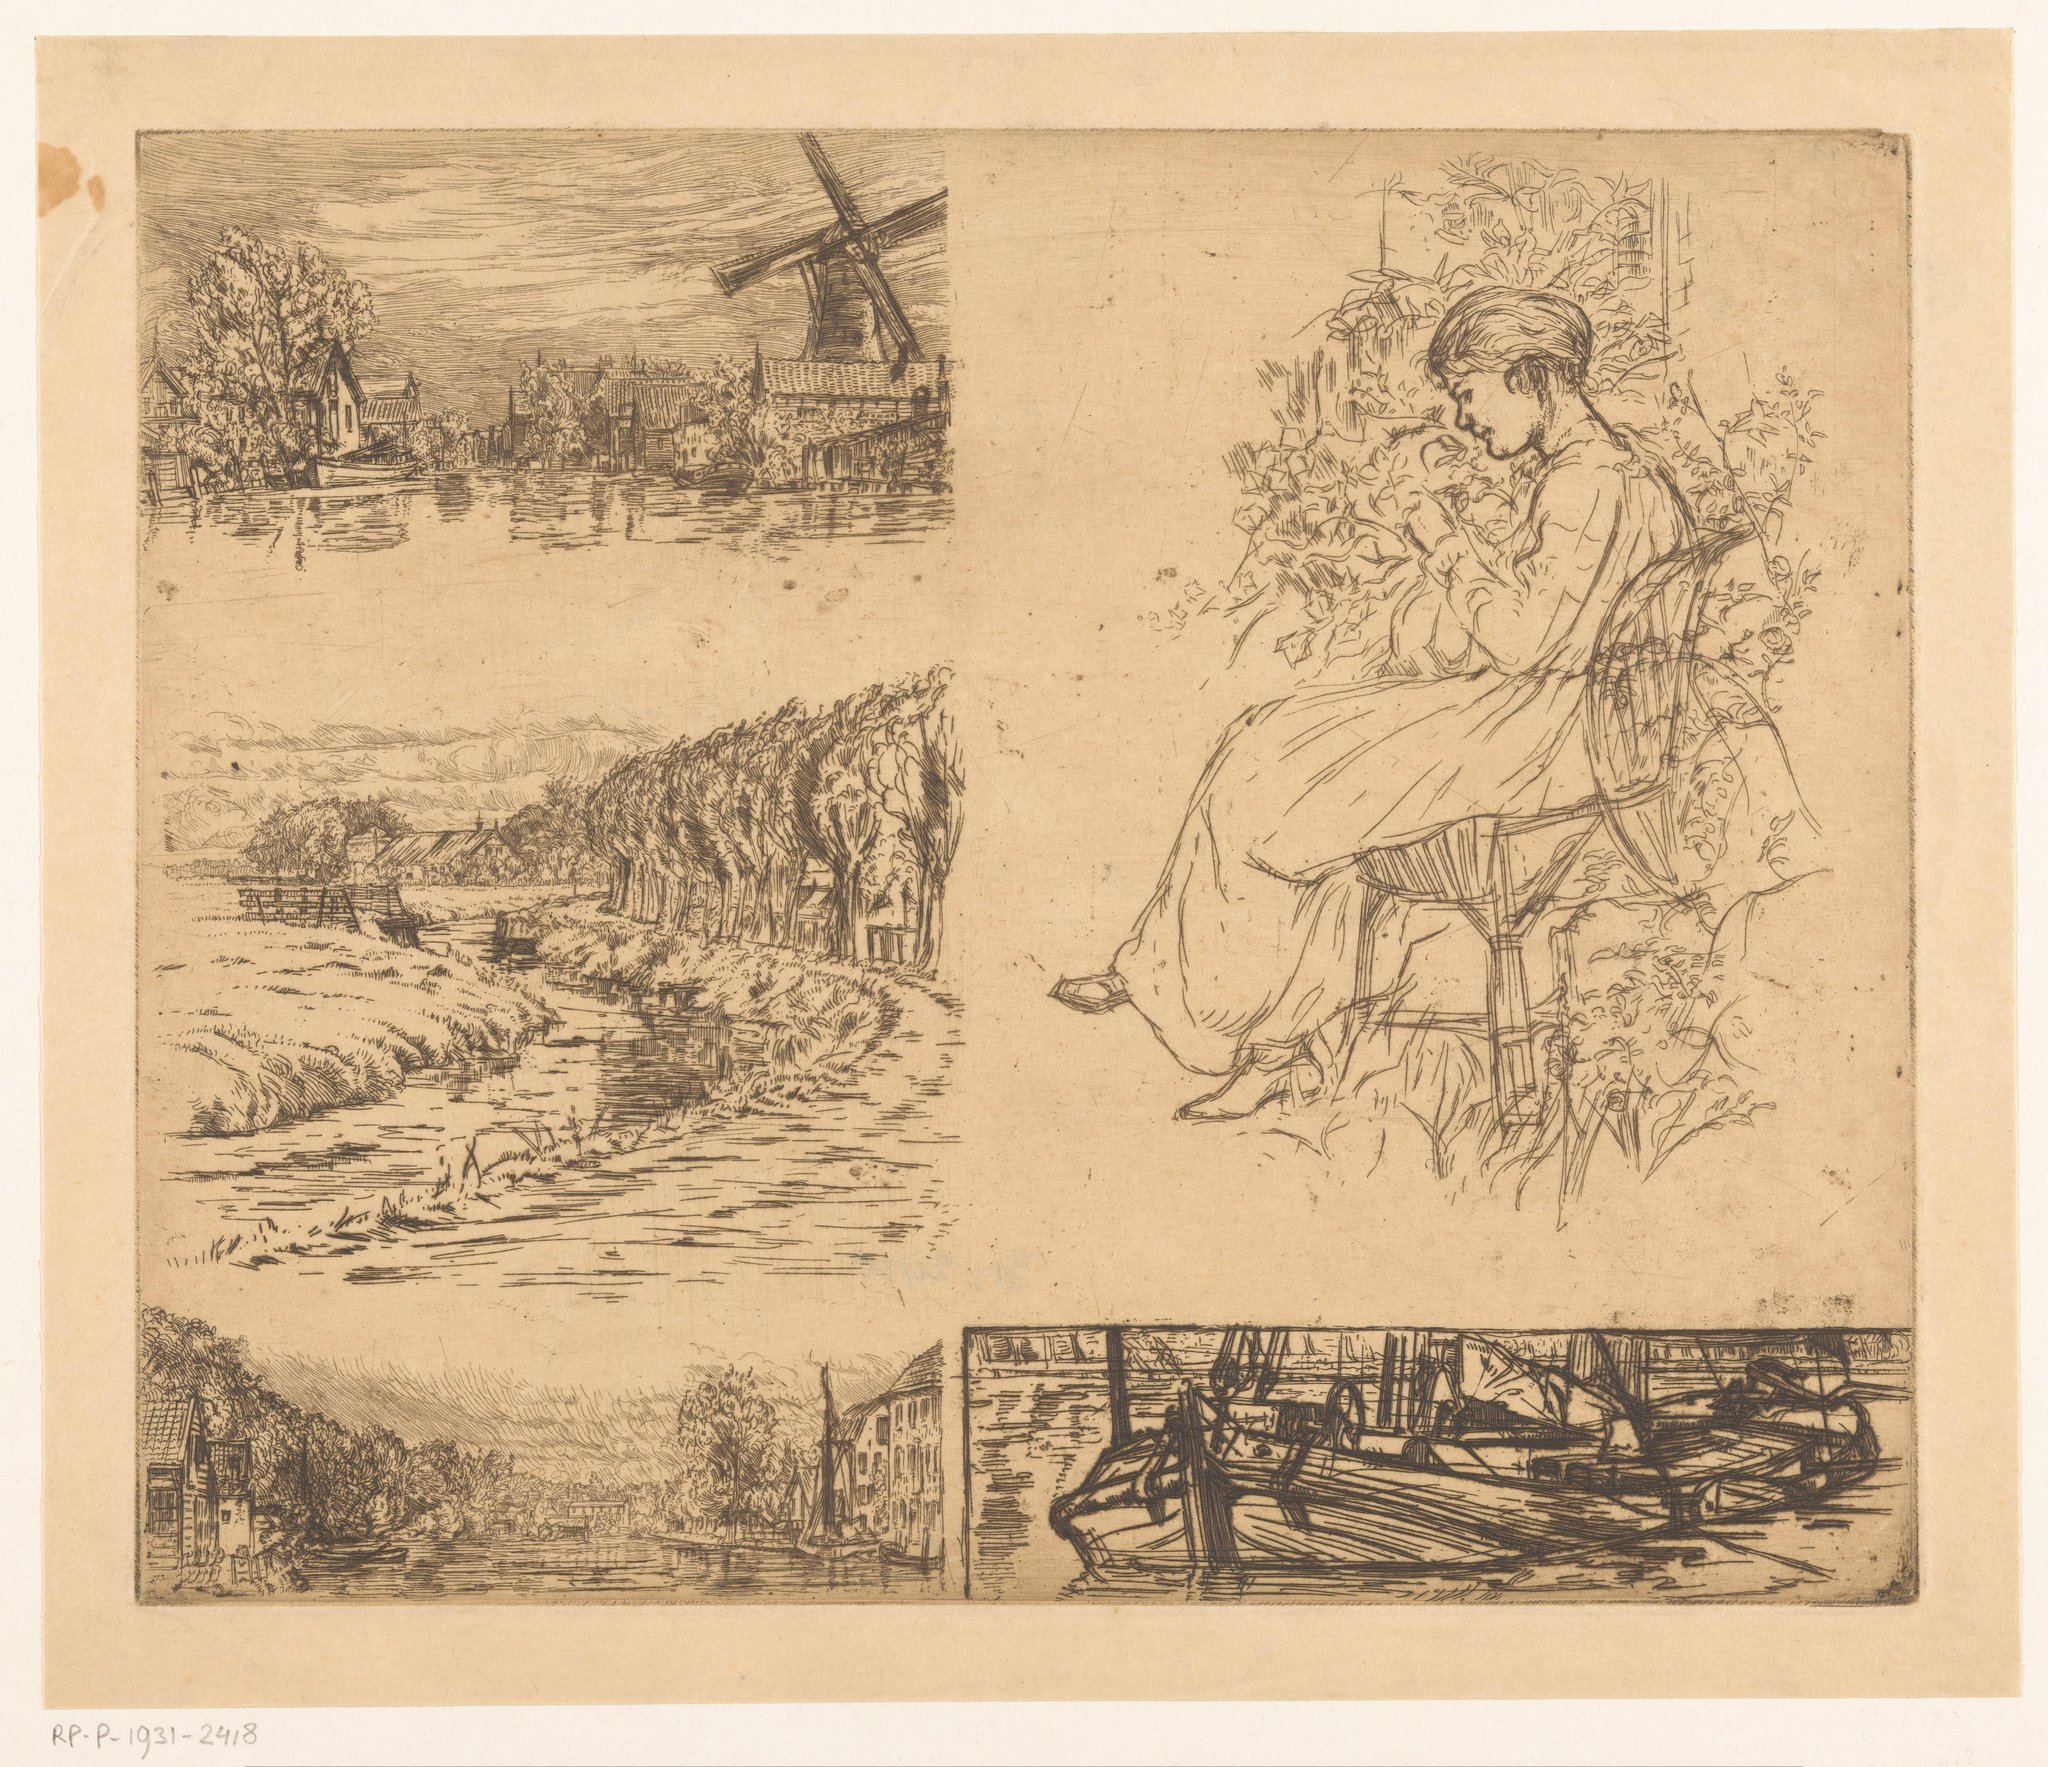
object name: print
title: Vijf studies van landschappen en een zittende vrouw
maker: johannes löhr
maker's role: print maker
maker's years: 1882-1928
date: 1892-1928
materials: paper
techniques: etching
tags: adolescent, young woman, maiden, sitting figure - aa - female human figure, ships (in general), village, windmill in landscape, small canal, ditch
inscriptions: collector's mark: Lugt 2228